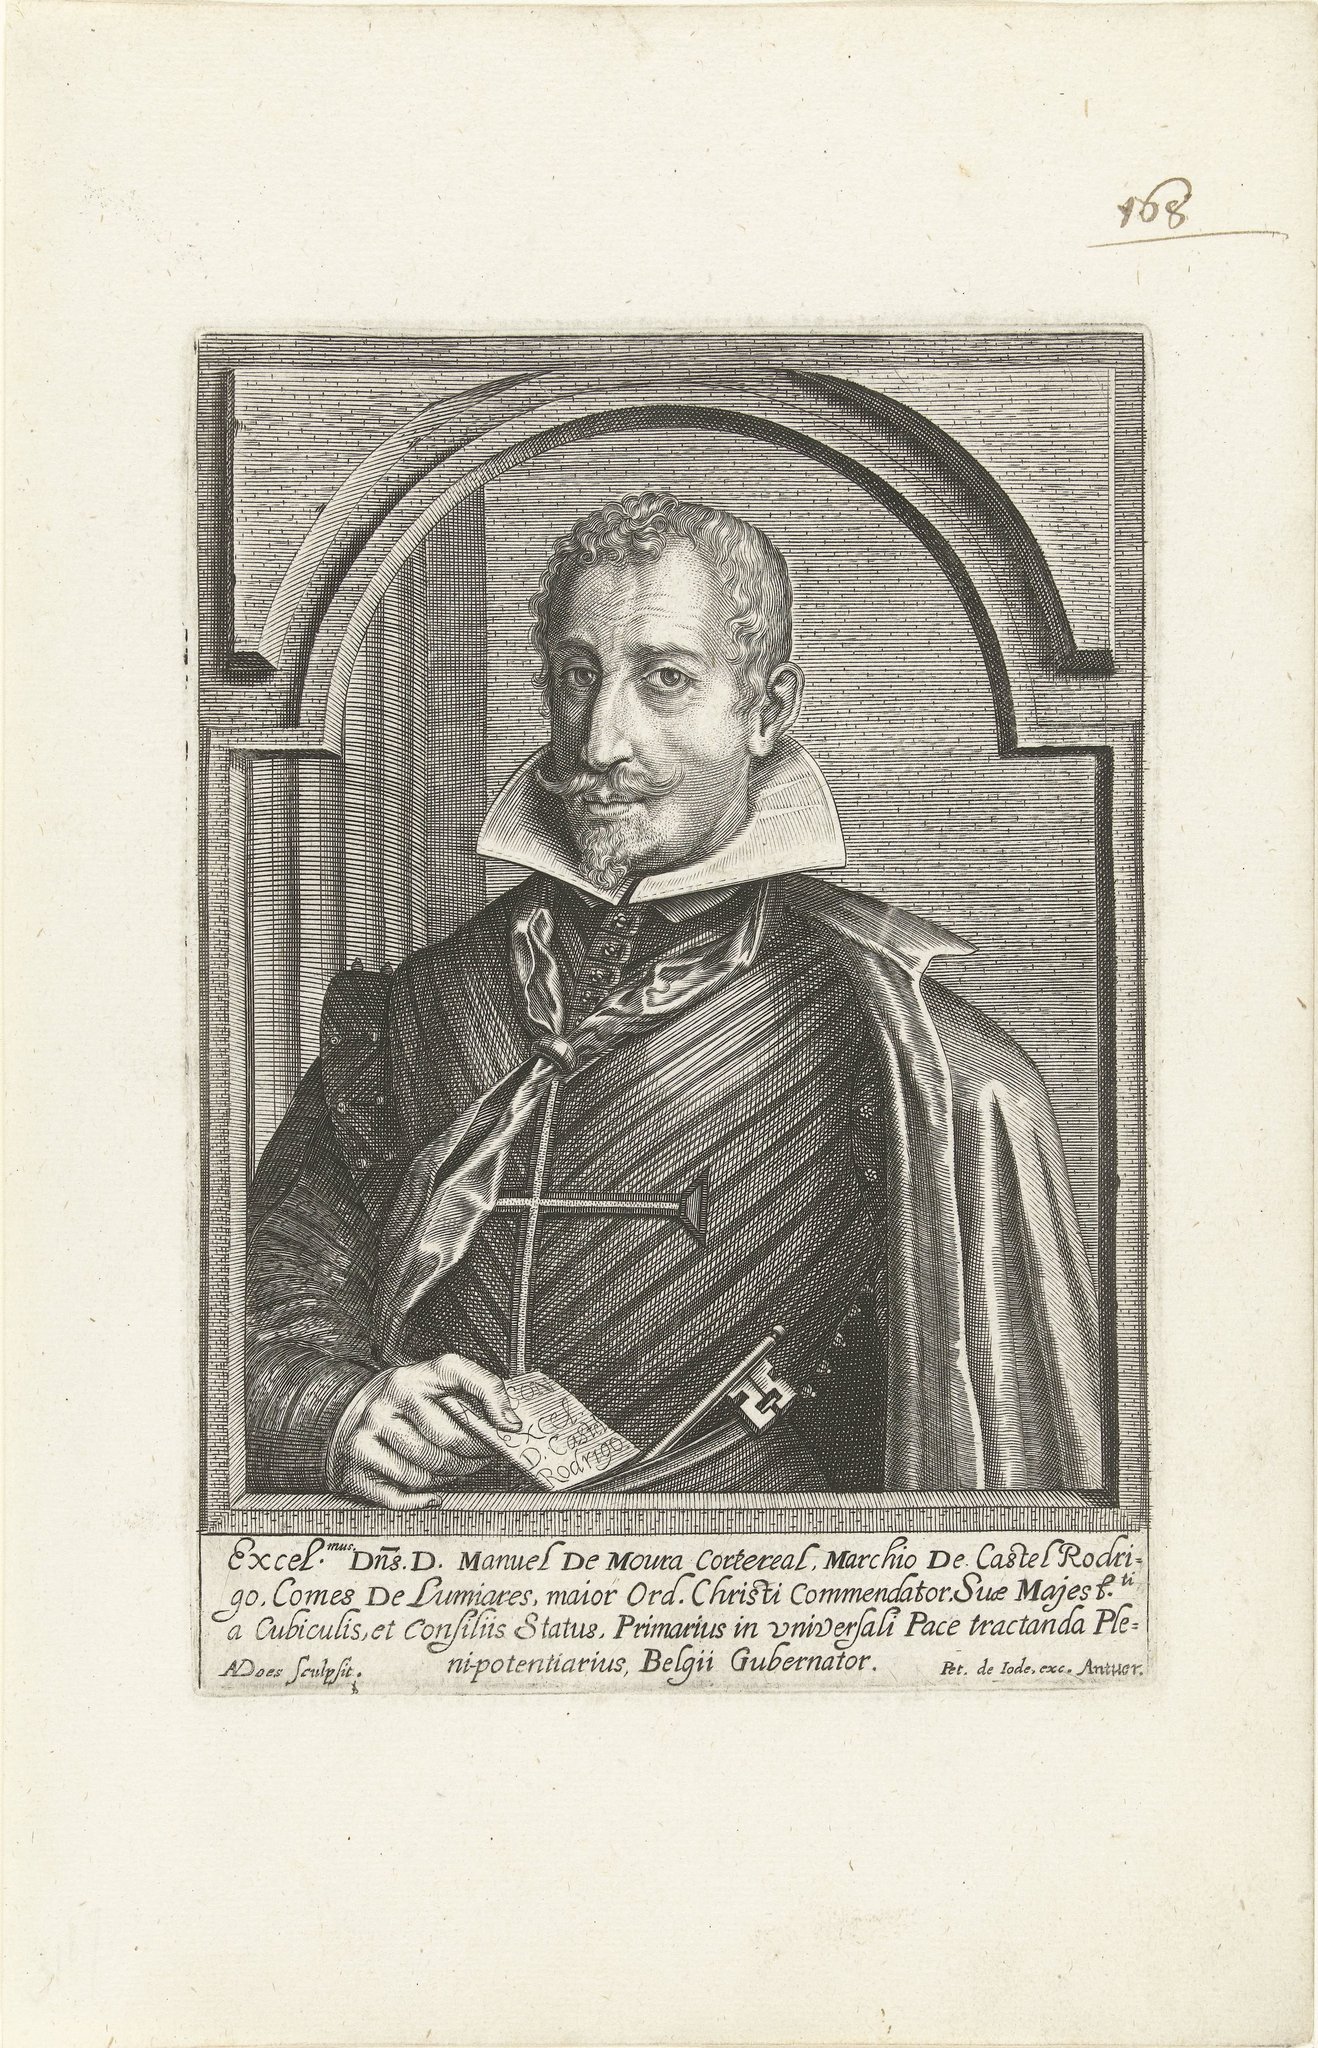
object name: print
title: Portret van Don Manuel de Castel Rodrigo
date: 1619-1680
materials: paper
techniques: engraving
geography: southern netherlands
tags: governor, etc. of province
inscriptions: collector's mark: Lugt 2228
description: Portret van gouverneur Don Manuel de Castel Rodrigo, halffiguur staand in rondbooglijst. In ondermarge vier regels Latijnse tekst.